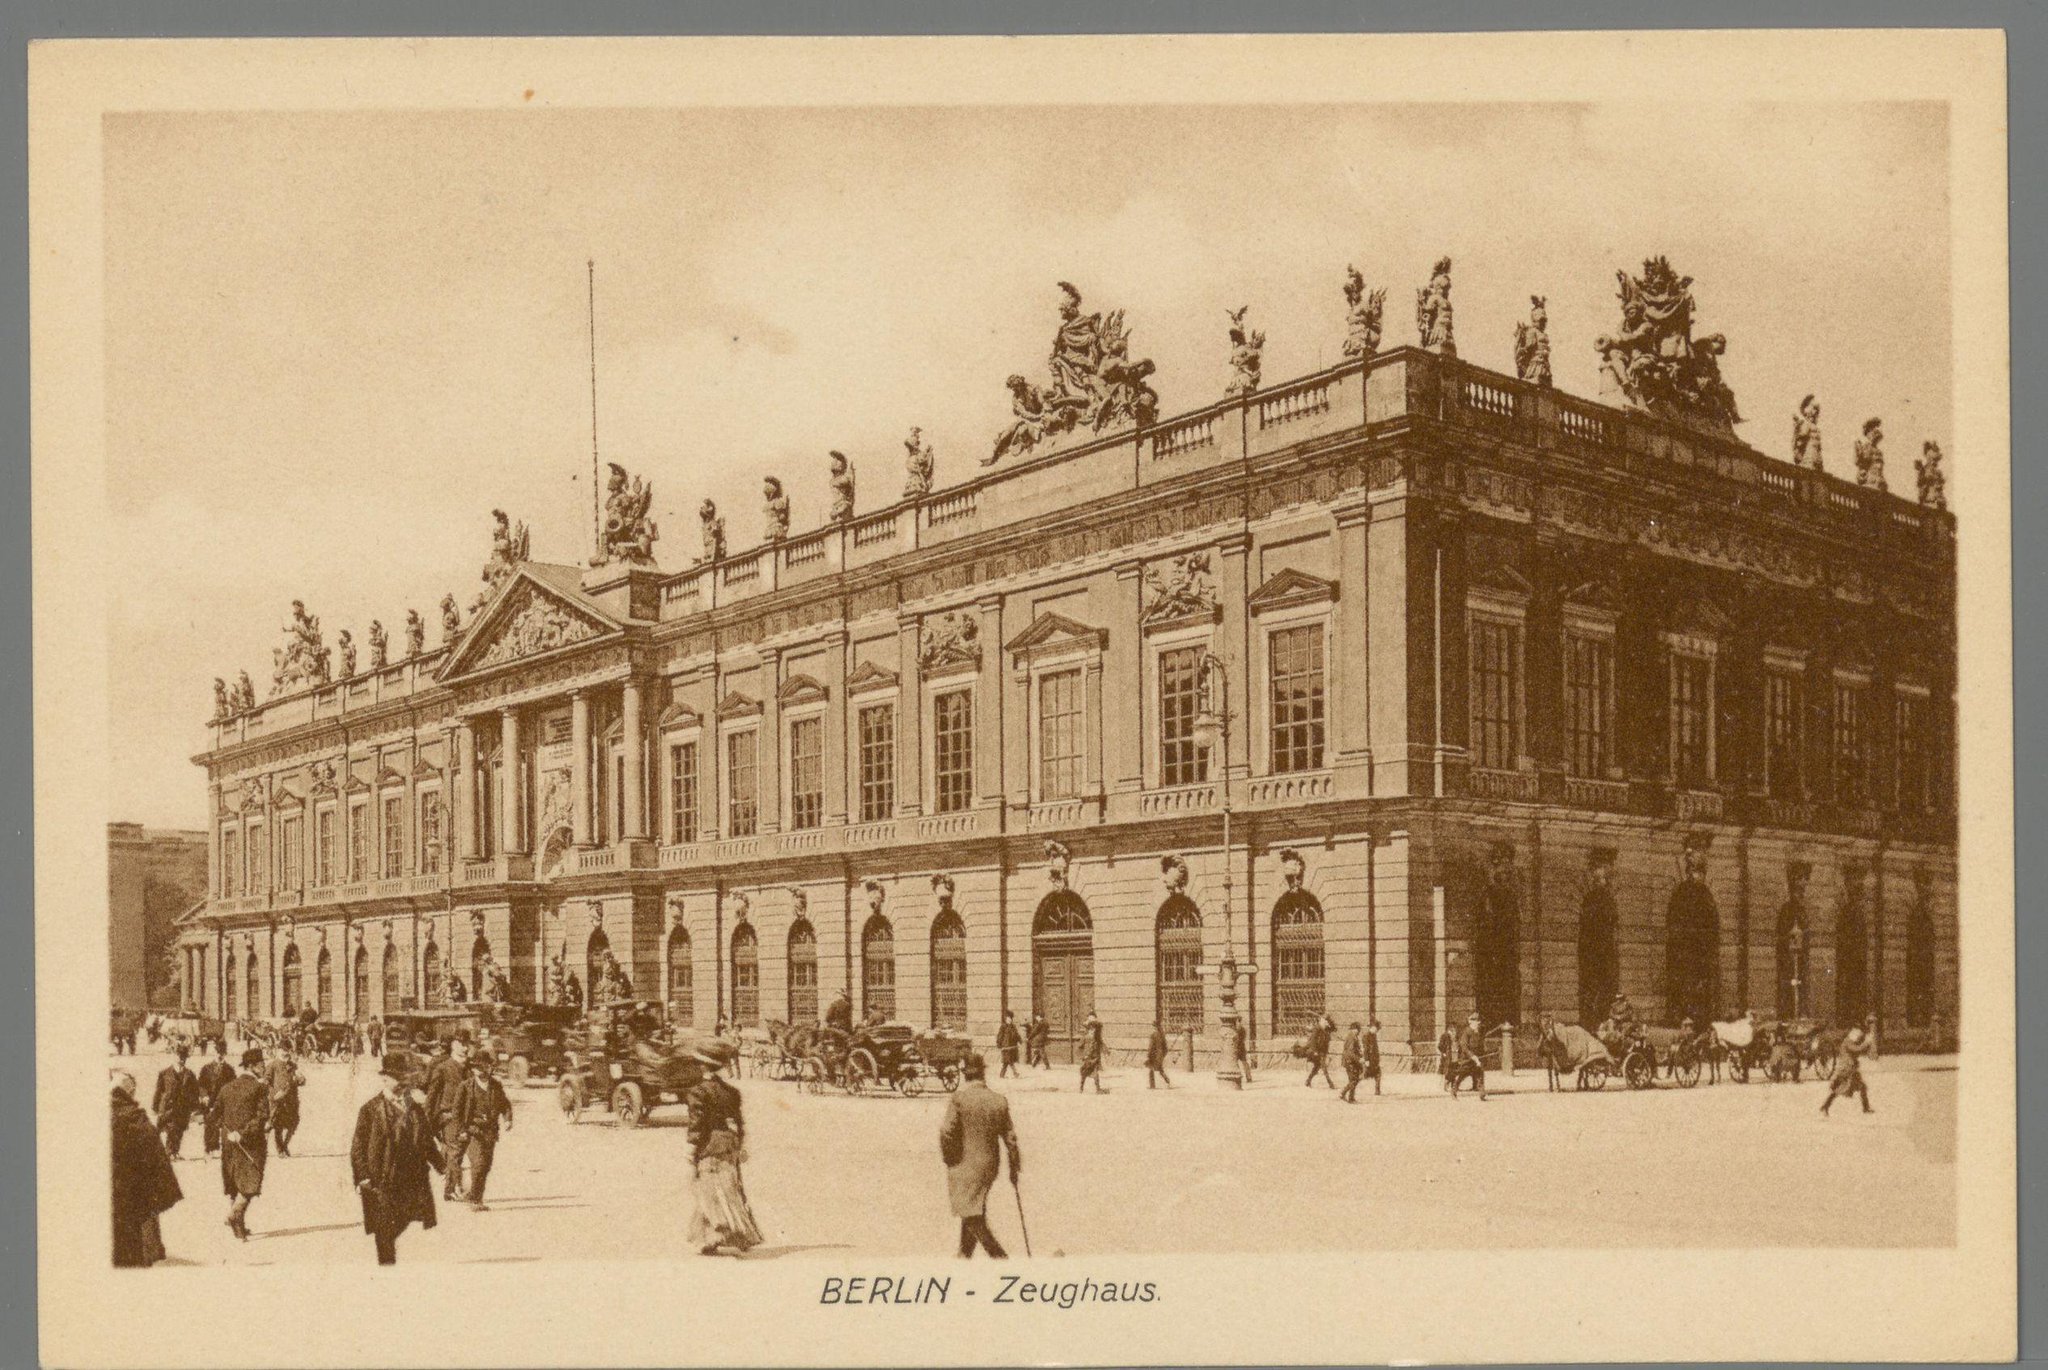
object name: photomechanical print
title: Berlin - Zeughaus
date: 1905-1910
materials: cardboard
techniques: photograph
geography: hamburg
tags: permanent exhibition, museum